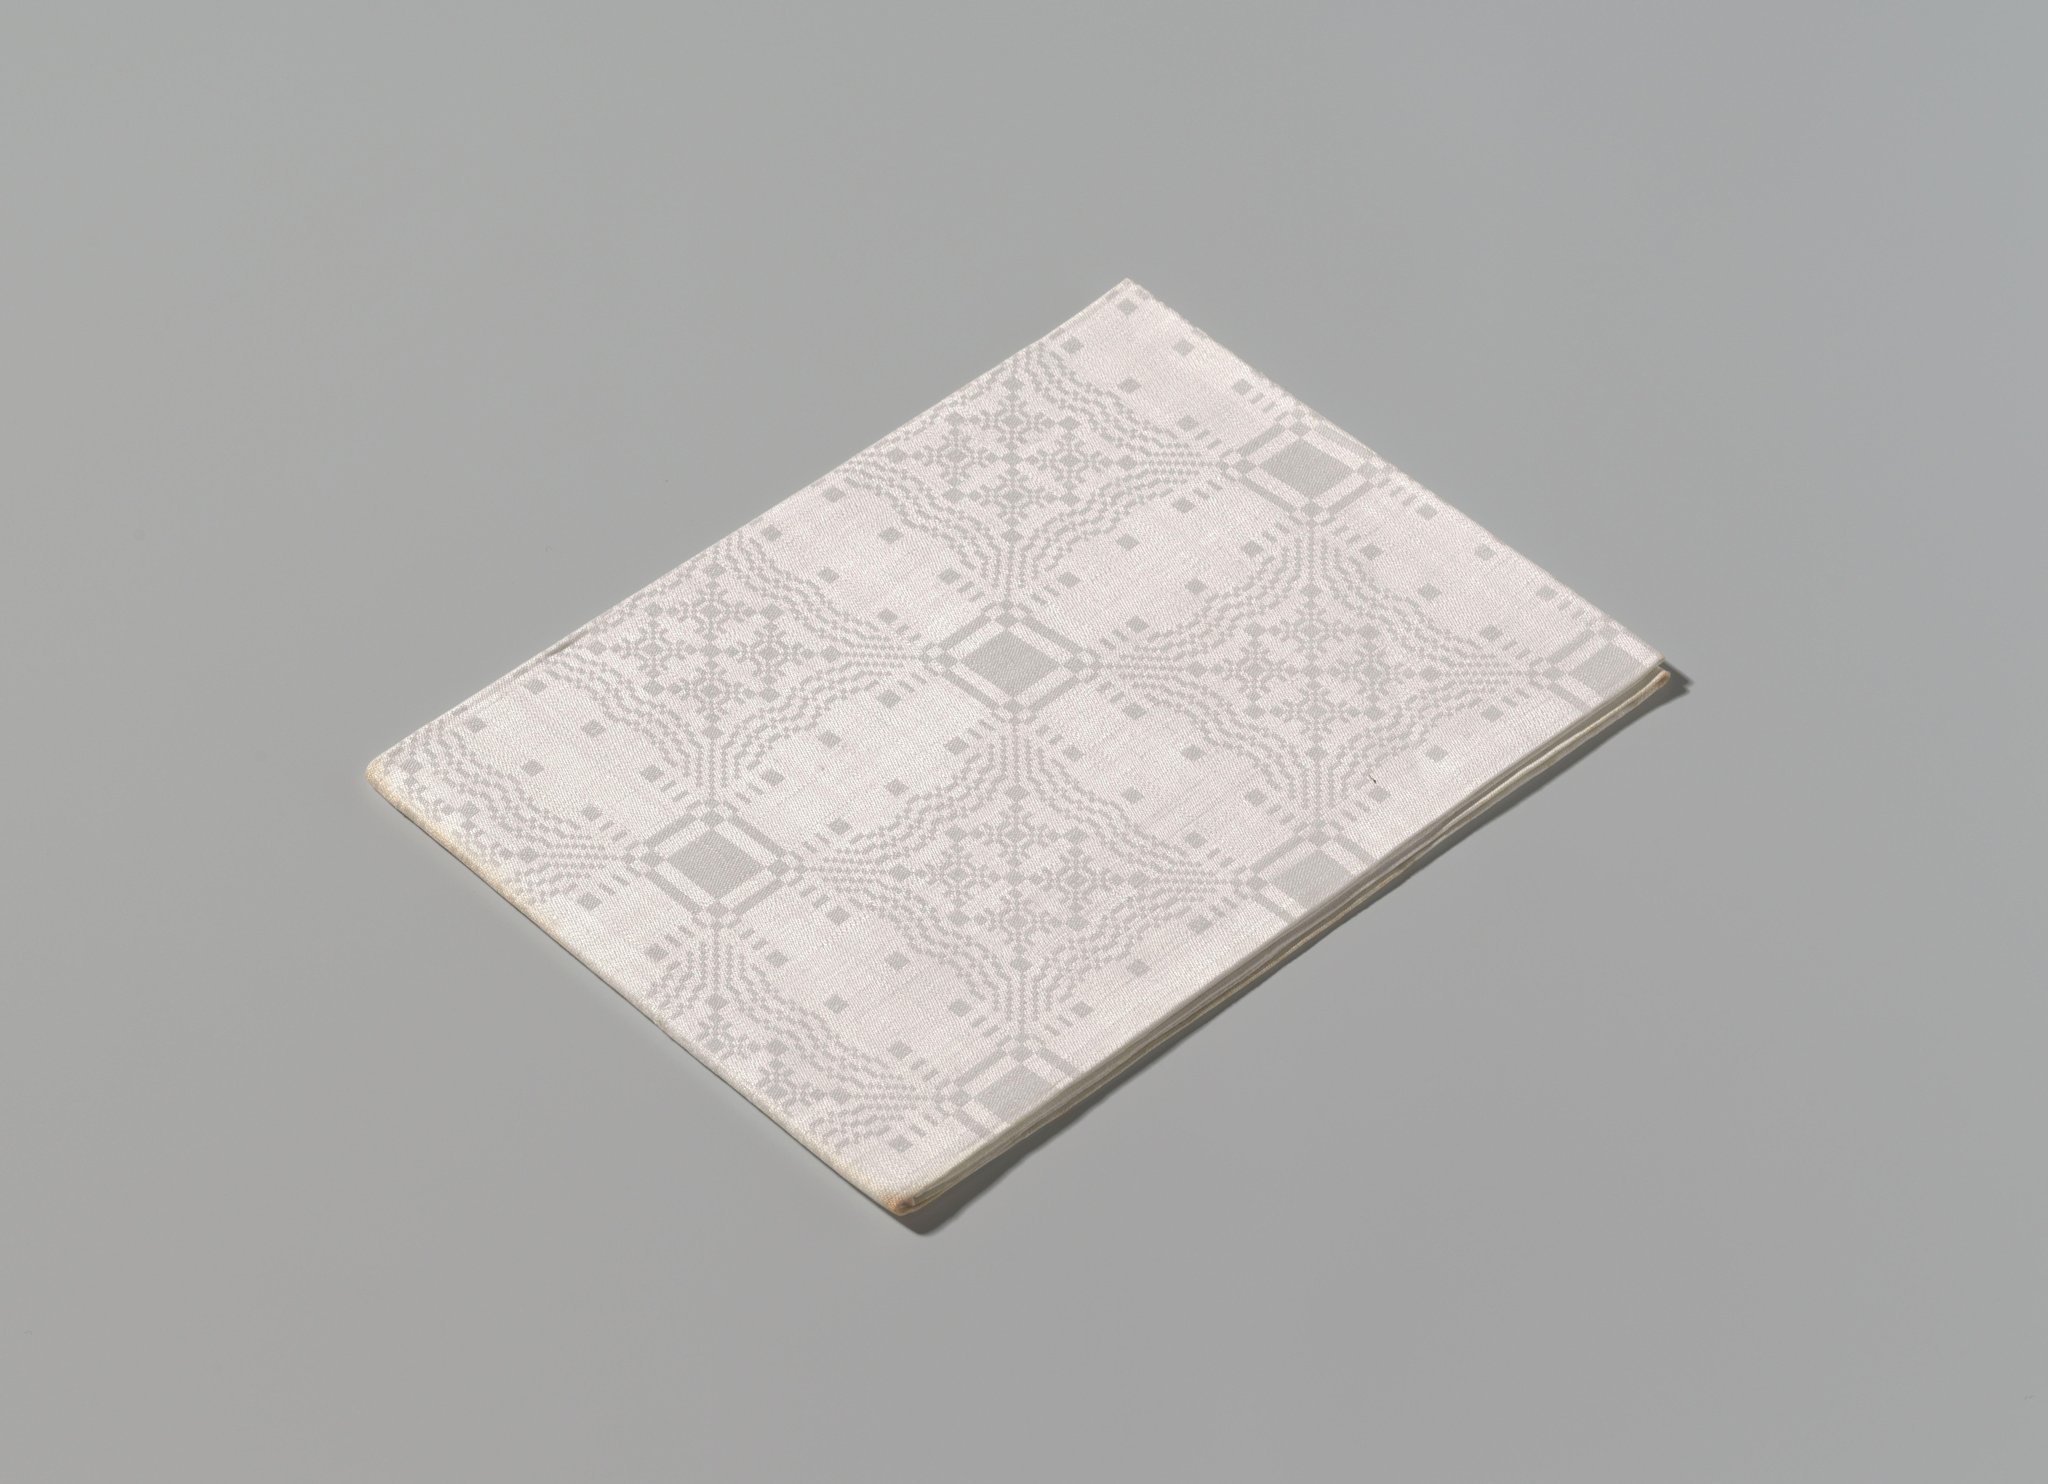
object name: napkin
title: Servet van linnen met pellenpatroon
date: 1725-1775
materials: linen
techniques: peeled fabric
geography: northern netherlands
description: Wit linnen servet met pellen patroon, merk IB HW.